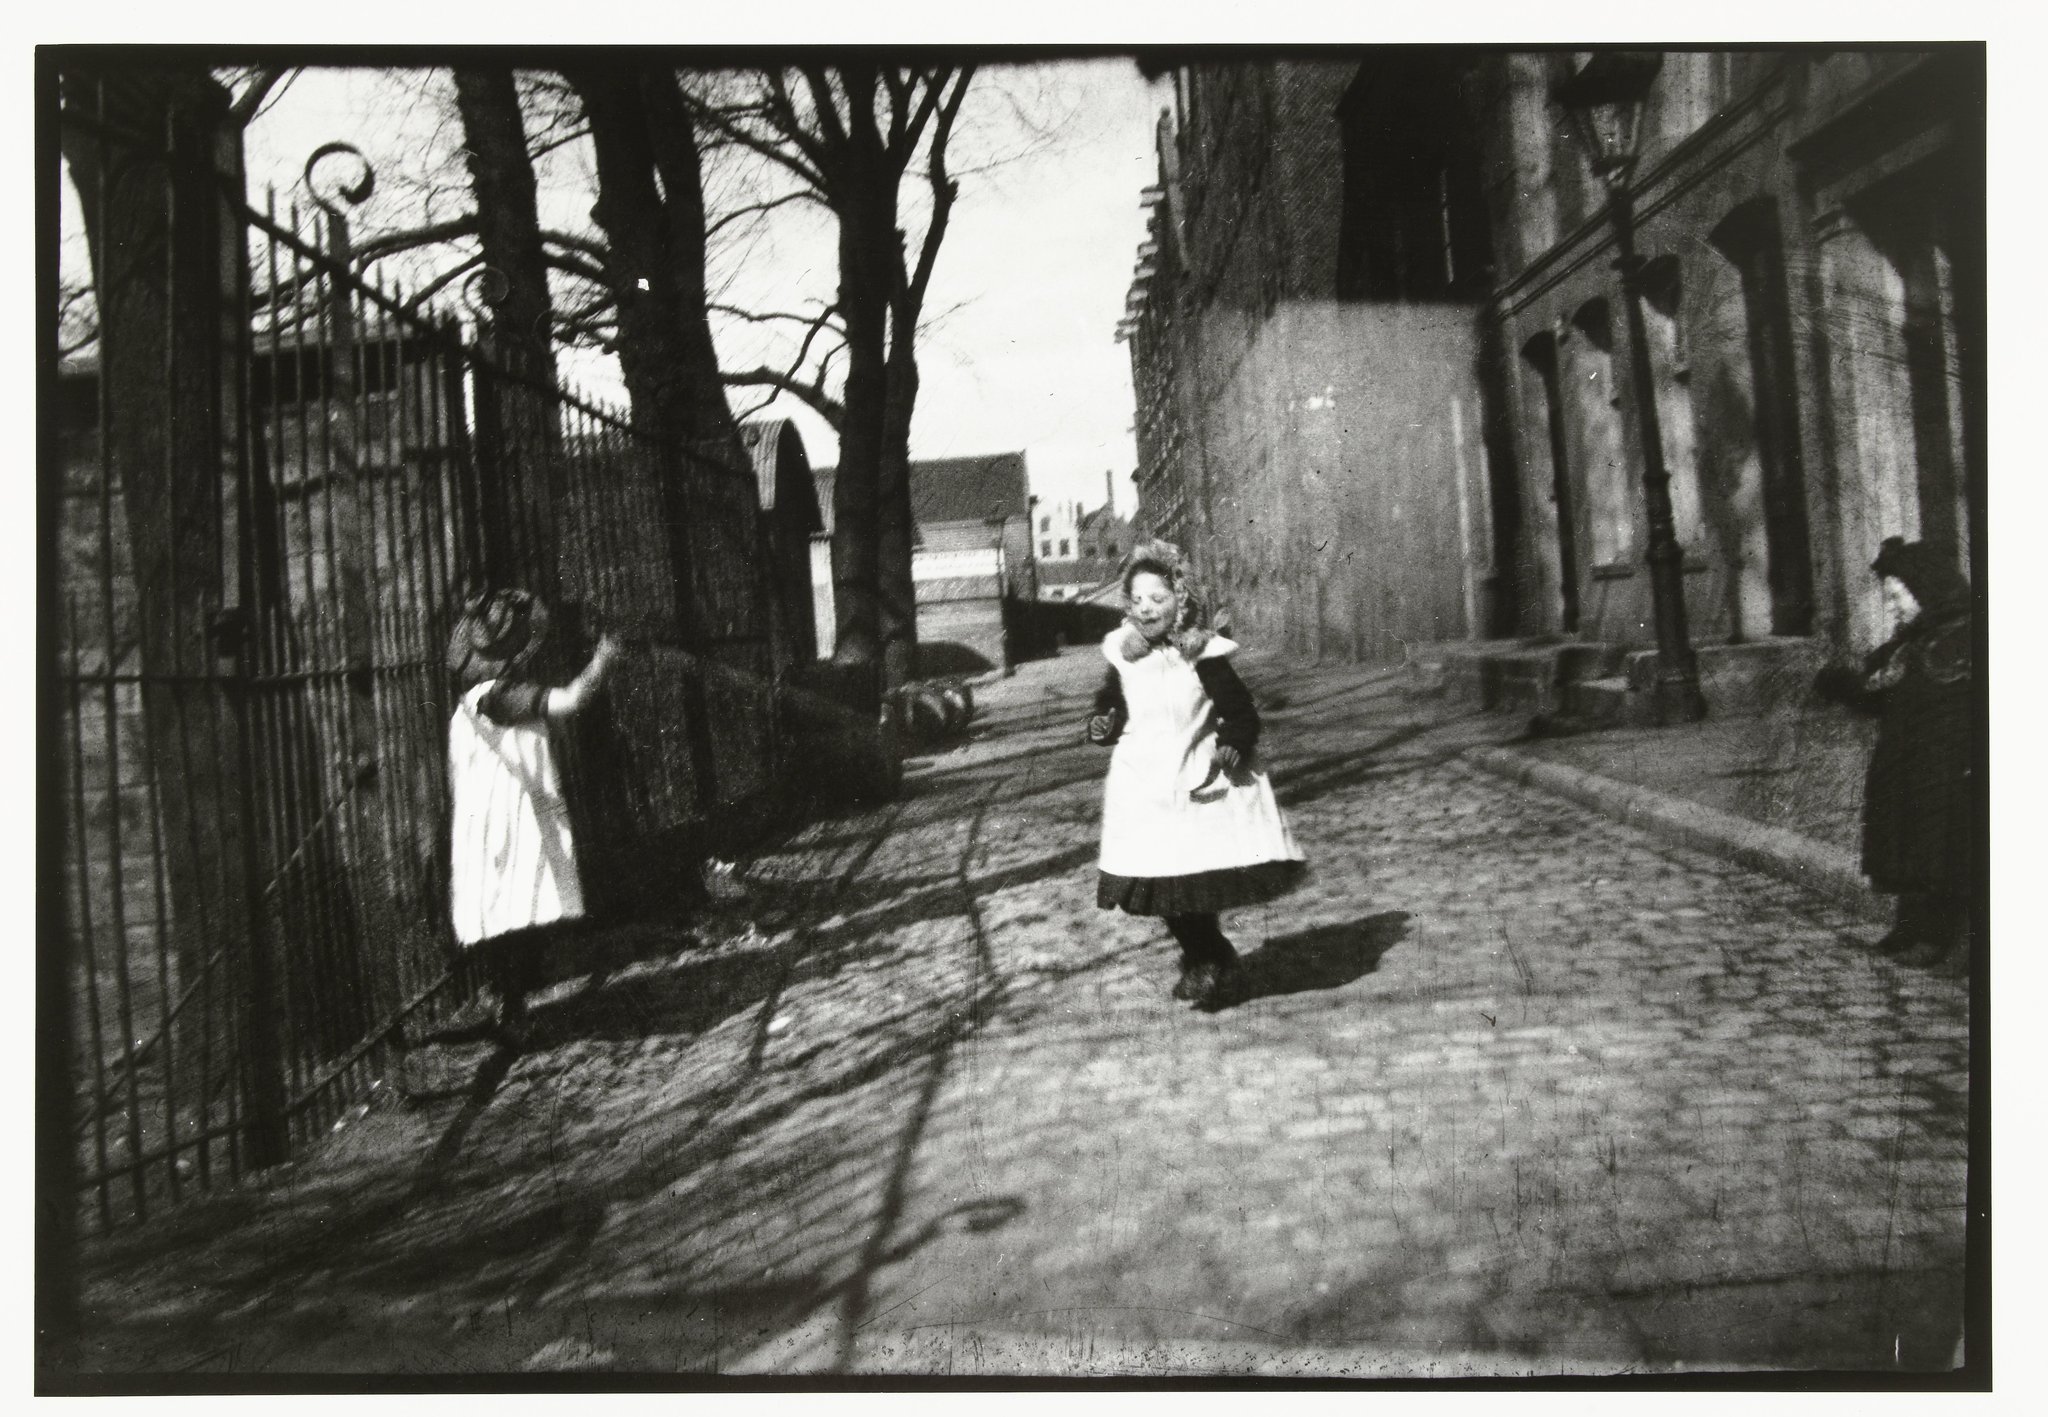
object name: photograph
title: Kinderen spelend voor ingang Breitners atelier op Prinseneiland in Amsterdam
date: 1890-1910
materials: paper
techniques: gelatin silver print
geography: amsterdam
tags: prinseneiland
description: Moderne afdruk van negatief BR 1370 (collectie RKD).